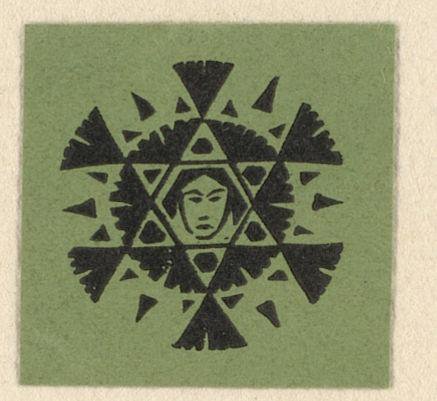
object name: book illustration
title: Sluitvignet met vrouwenhoofd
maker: gerrit willem dijsselhof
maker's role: designer, draughtsman, print maker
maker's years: 1866-1924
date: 1893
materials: paper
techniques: galvanoplasty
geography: amsterdam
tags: face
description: Sluitvignet gebruikt in: Crane, Walter. Kunst en samenleving. [Vertaald uit het Engels door] Jan Veth. Amsterdam: Scheltema & Holkema's Boekhandel, 1894 [1893], p. 32. Later zijn deze afbeeldingen door de uitgever veelvuldig gebruikt voor andere uitgaven. Zie bijvoorbeeld RP-P-1969-415, een catalogus van de in 1894 bij Scheltema & Holkema's Boekhandel verkrijgbare publicaties.